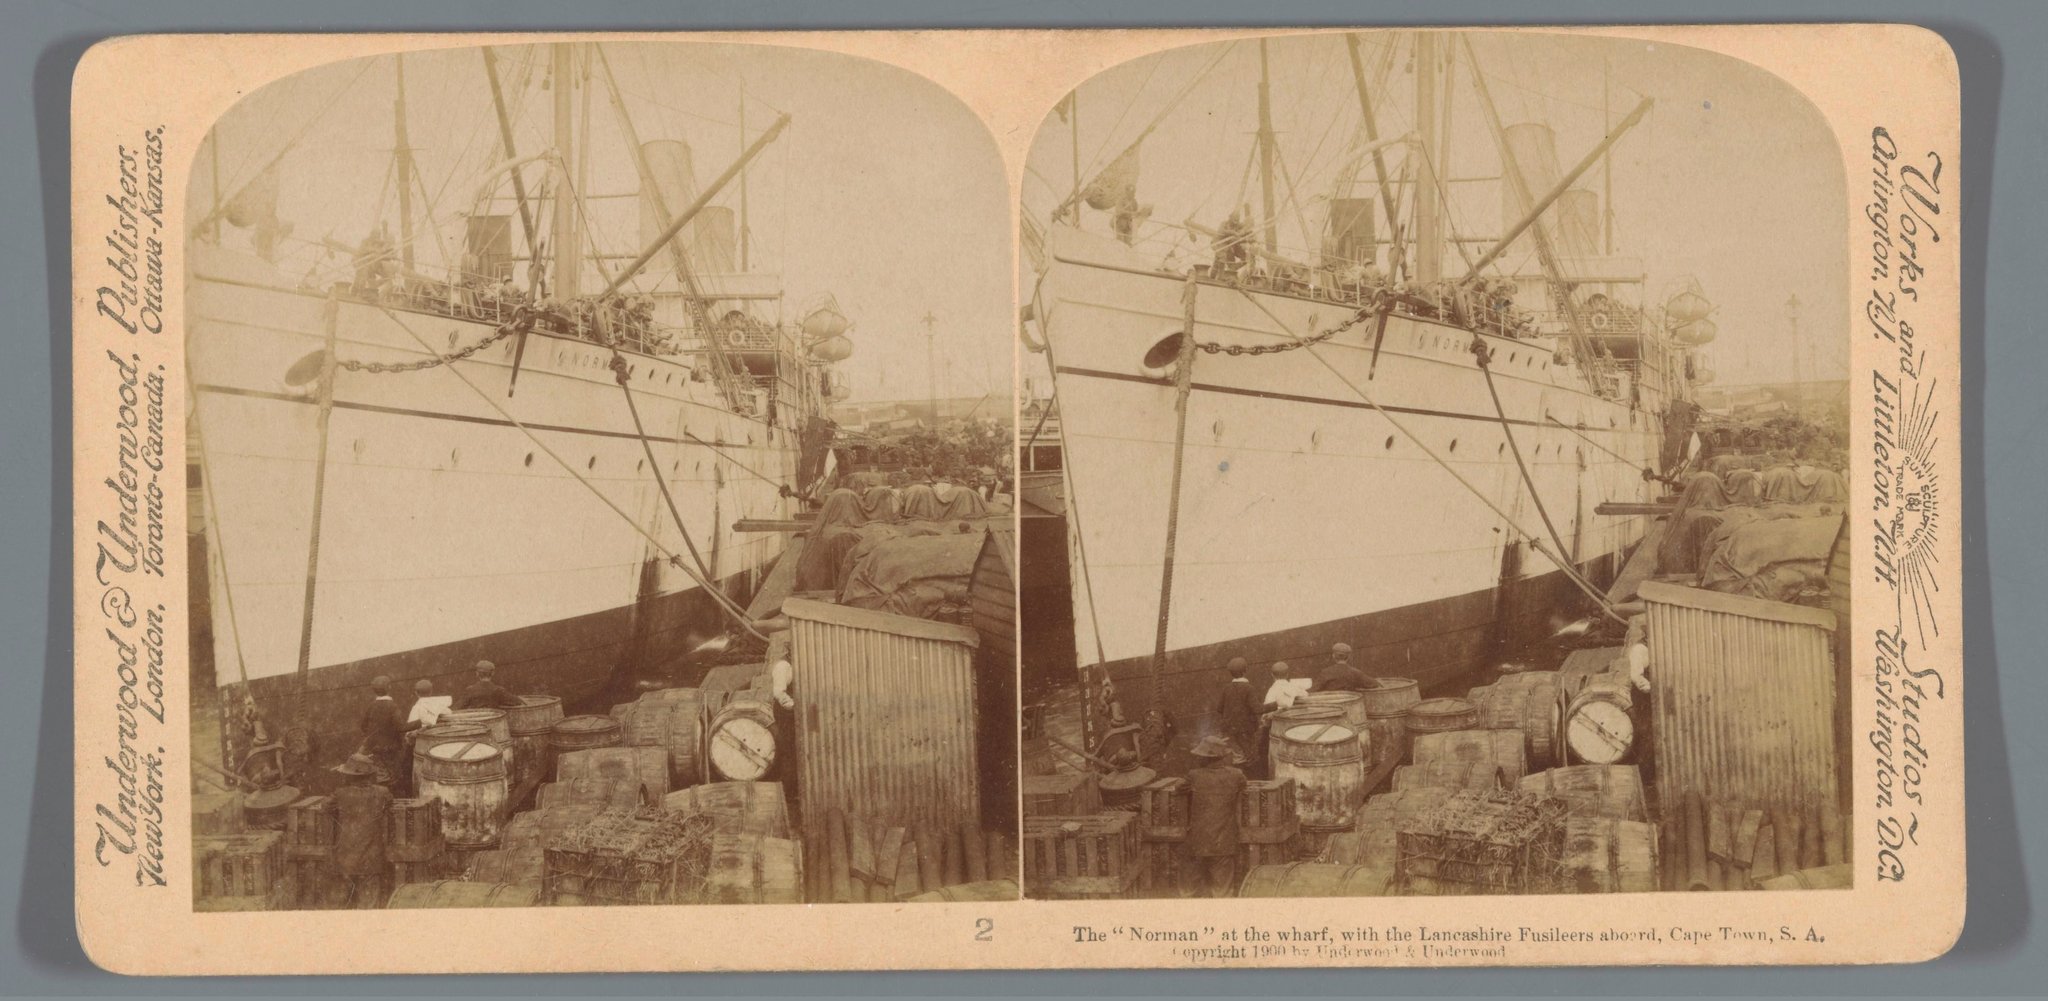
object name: stereograph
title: The "Norman" at the wharf with the Lancashire Fusileers aboard, Cape Town, South Africa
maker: Anonymous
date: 1900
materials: cardboard, paper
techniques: albumen print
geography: new york city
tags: ships (in general)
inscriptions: copyright notice: ‘Copyright 1900 by Underwood & Underwood.’, number: ‘2’, inscription: ‘Works and Studios ~/ Arlington, N.J. Littleton, N.H. Washington, D.C.’, inscription